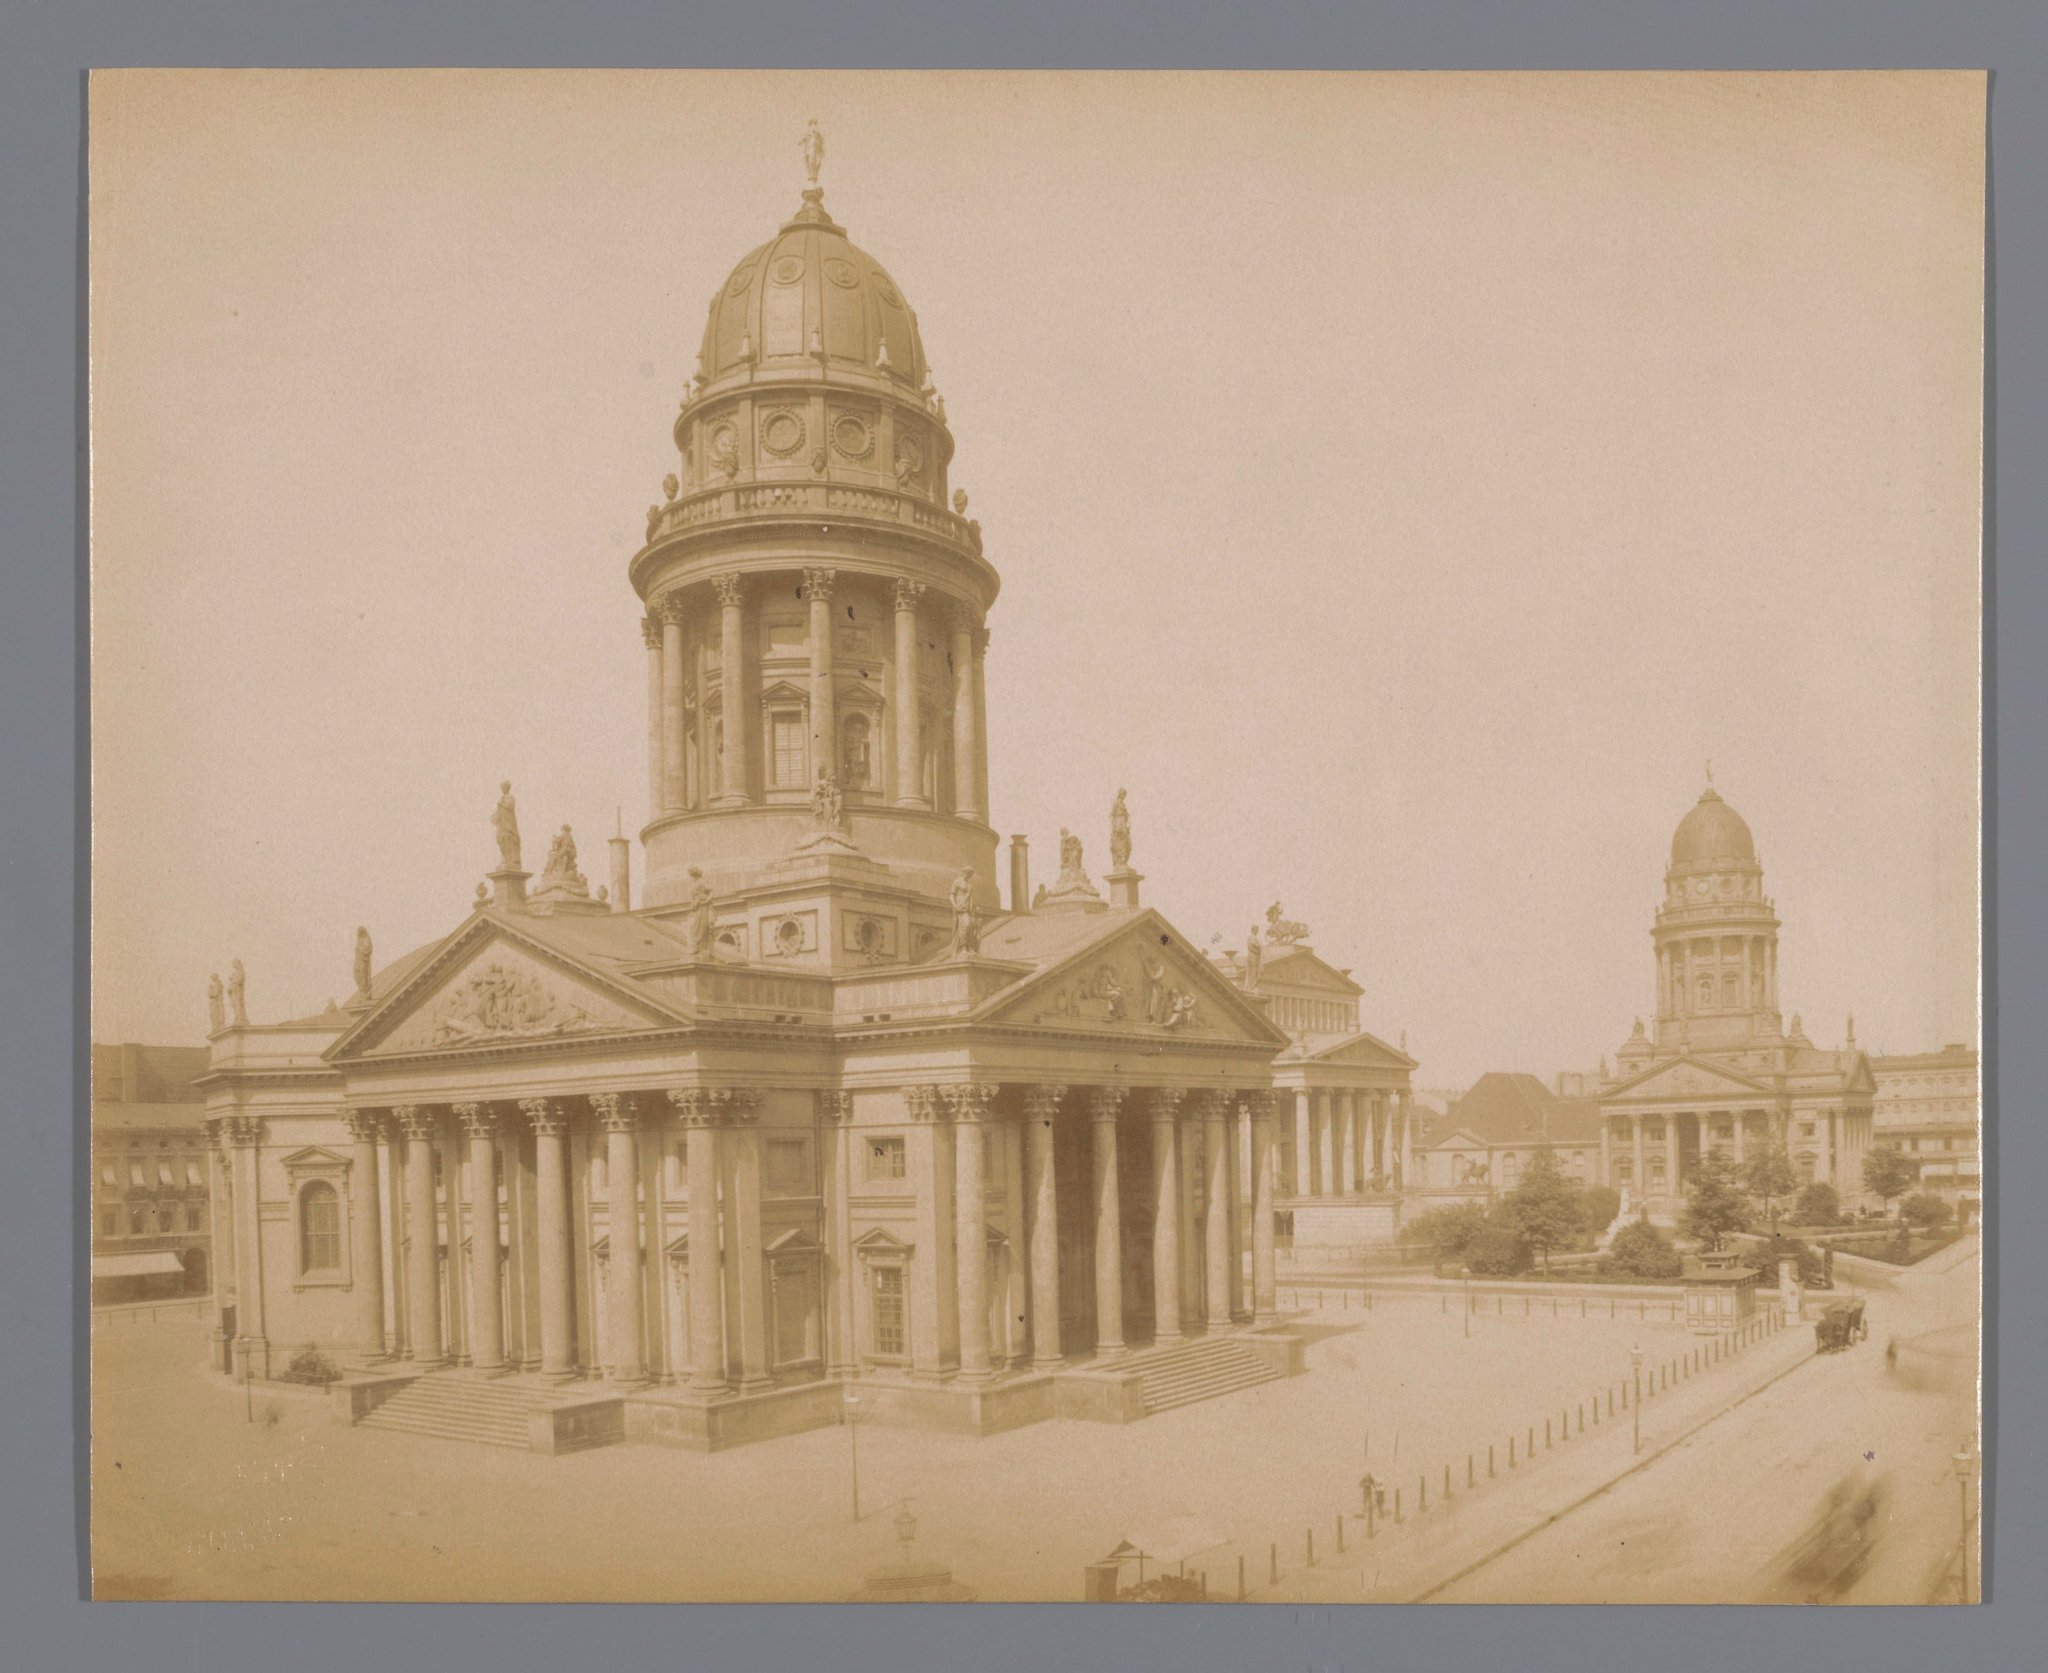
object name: photograph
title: Berlin, Schillerplatz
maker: friedrich albert schwartz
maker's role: fotograaf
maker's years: 1836-1906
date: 1892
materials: paper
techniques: albumen print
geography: berlin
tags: church (exterior)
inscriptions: inscription: ‘Berlin Gendarmen Markt in de verte/ Schillerplatz mit Franz. Kirche/ Schauspielhaus/ Neue Kirche’, check stamp: ‘Artist.-Photogr. Gesellschaft/ F. Albert/ Berlin-W.’, date: ‘1892’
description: Met op de voorgrond de Deutscher Dom, op de achtergrond de Französischer Dom, met daartussenin het concertgebouw en de Schillerplatz.